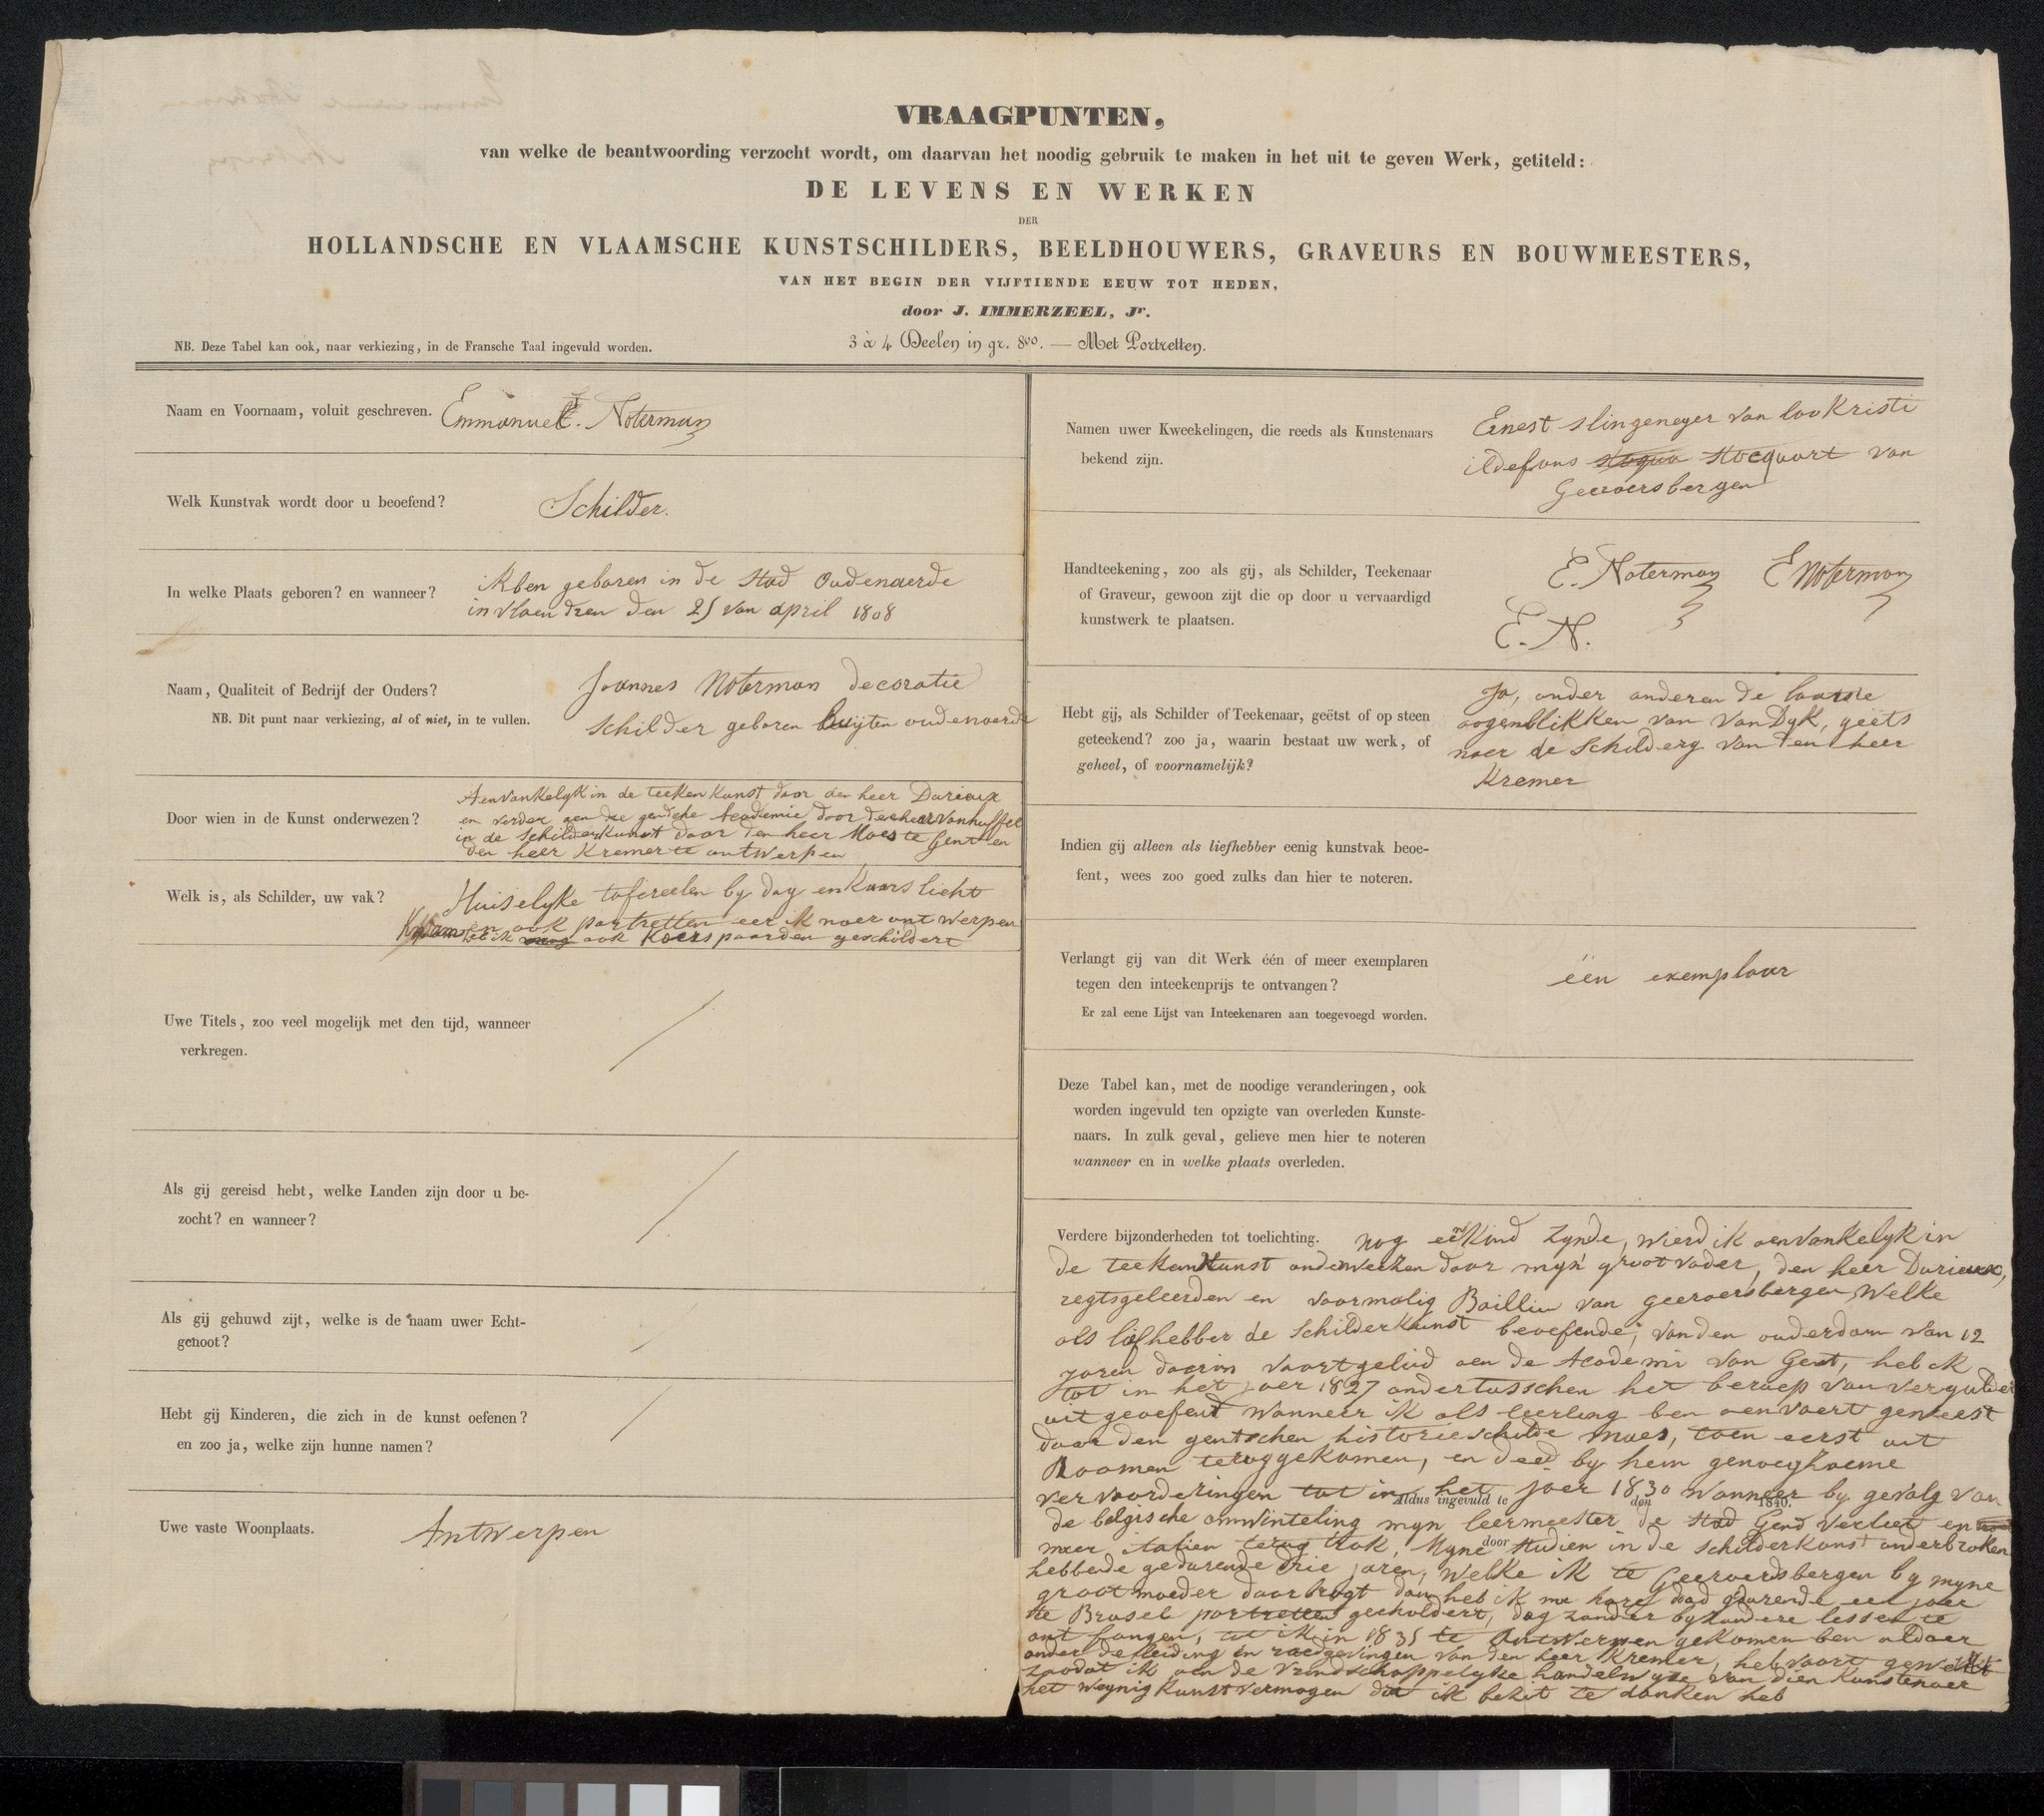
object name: questionnaire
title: Enquêteformulier ingevuld door Emanuel Noterman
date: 1840-1841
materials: ink, paper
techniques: pen, printing, writing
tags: print maker, draughtsman, emanuel noterman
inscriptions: inscription: ‘Vraagpunten,/ van welke de beantwoording verzocht wordt, om daarvan het noodig gebruik te maken in het uit te geven Werk, getiteld: De levens en werken/ der Hollandsche en Vlaamsche kunstschilders, beeldhouwers,/ graveurs en bouwmeesters, van het begin der vijftiende eeuw tot heden/ door J. Immerzeel, Jr.’, watermark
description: Opgenomen in: Immerzeel, J. Jr., De levens en werken der Hollandsche en Vlaamsche kunstschilders, beeldhouwers, graveurs en bouwmeesters, van het begin der vijftiende eeuw tot heden, Amsterdam: J.C. van Kesteren, 1842-1843.